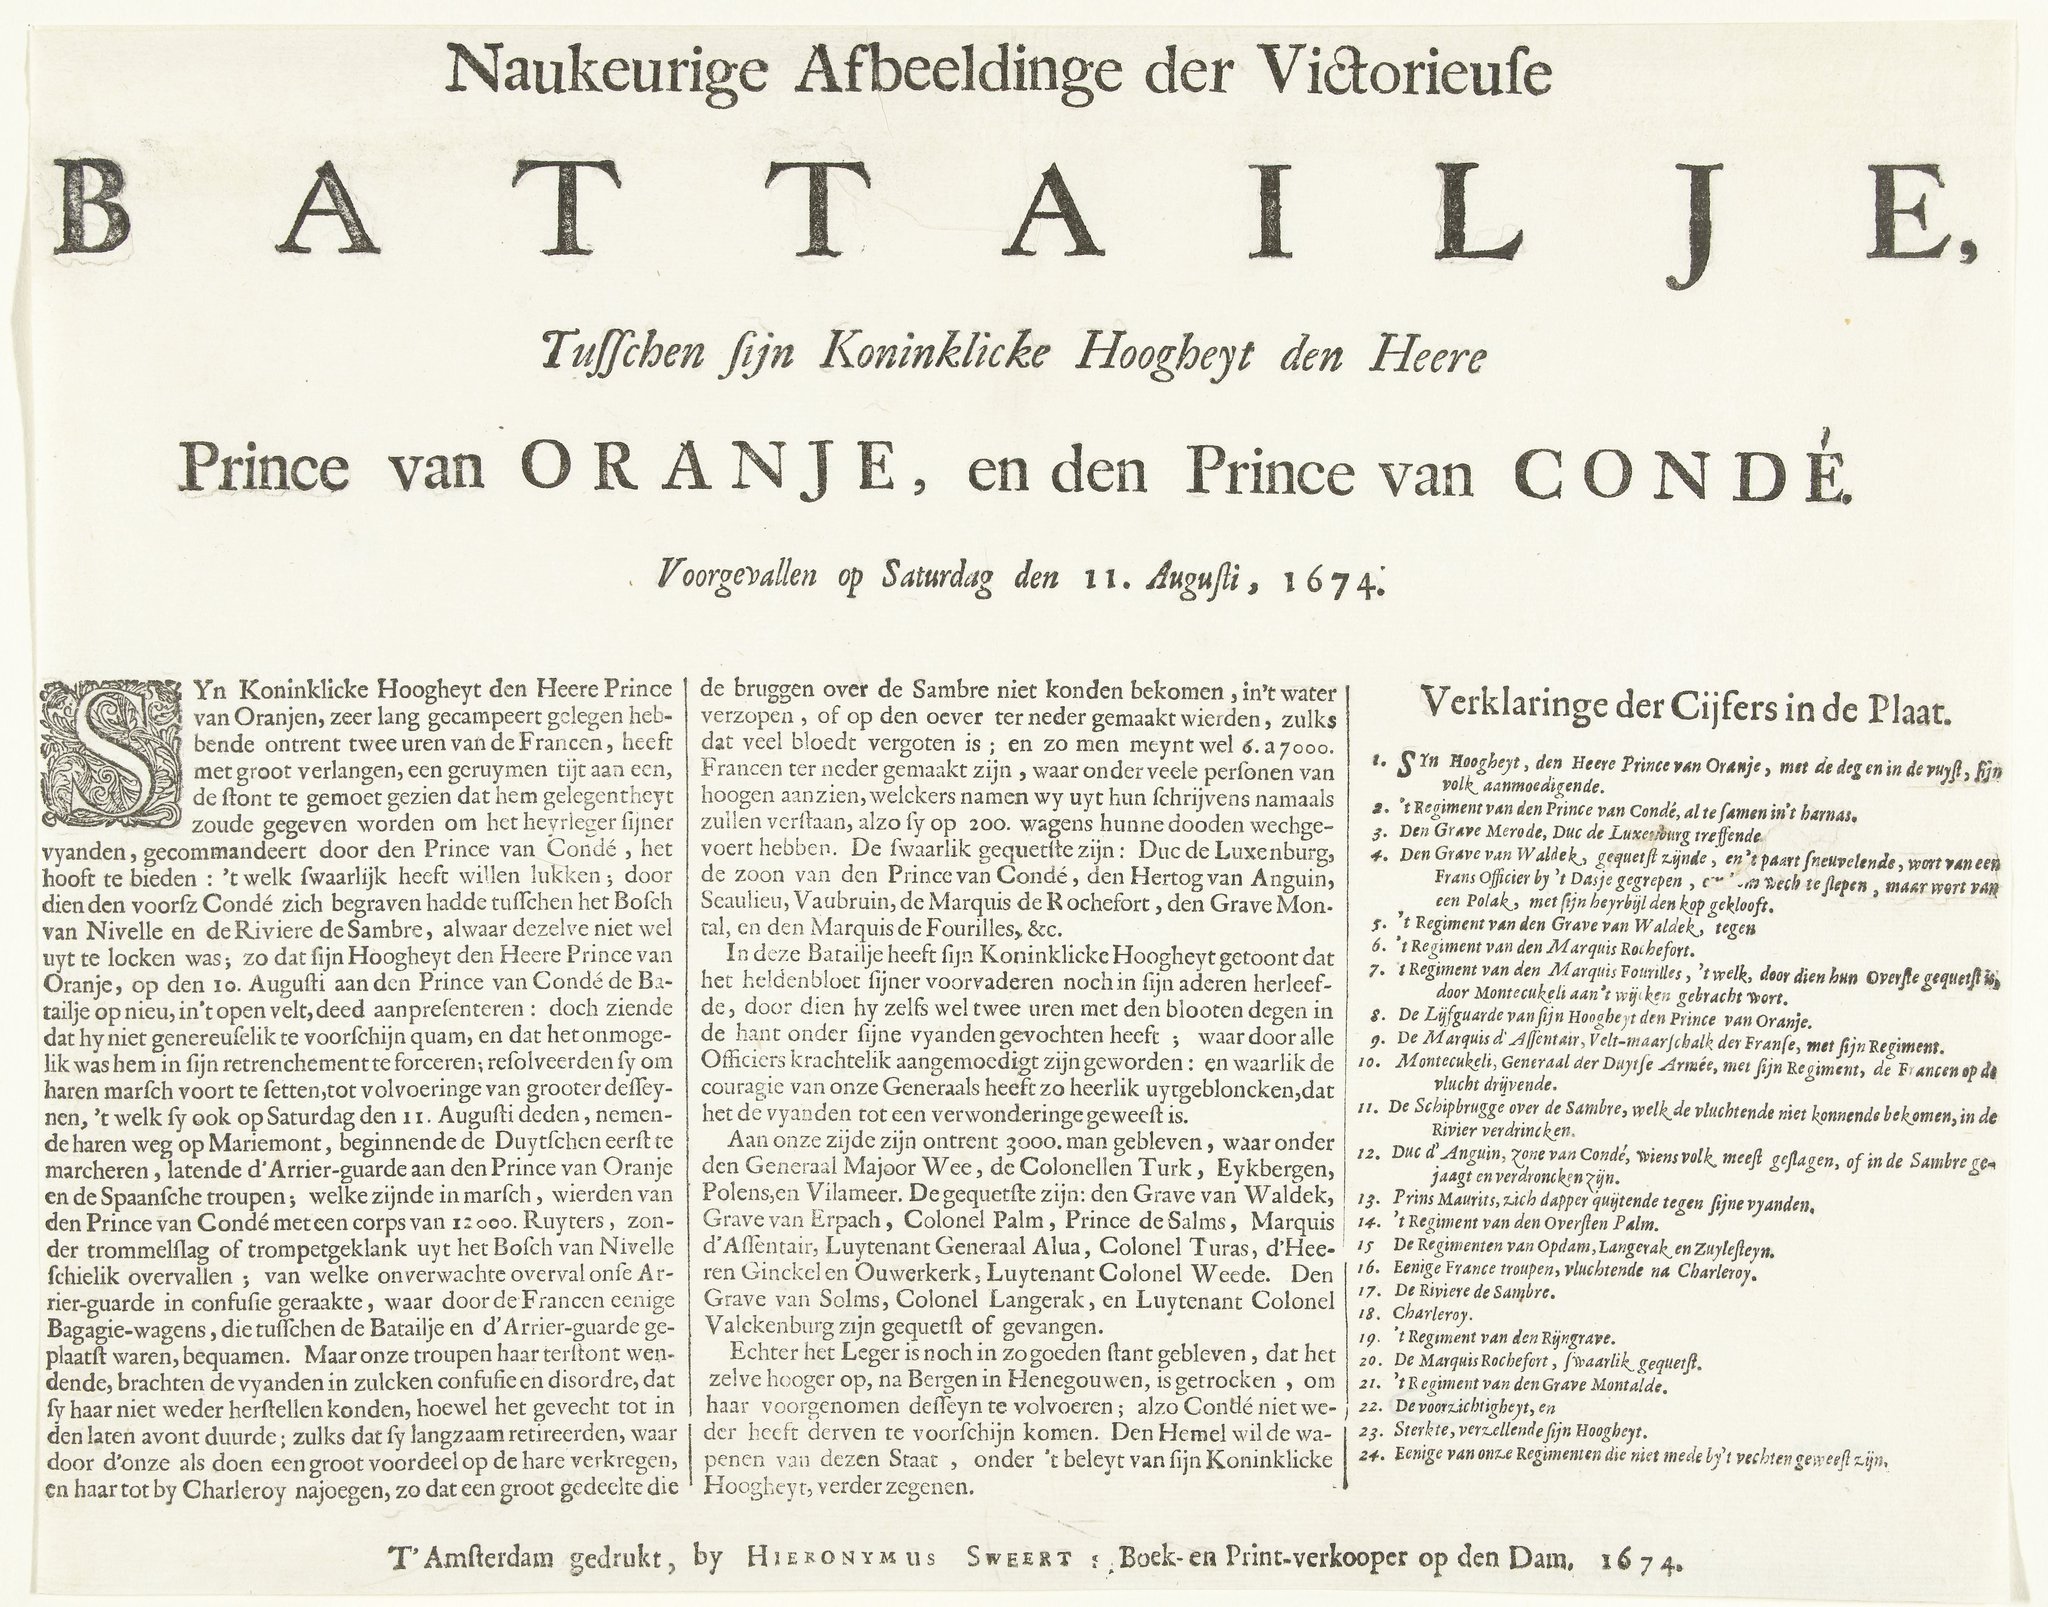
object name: text sheet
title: Naukeurige Afbeeldinge der Victorieuse Battailje, Tusschen sijn Koninklicke Hoogheyt den Heere Prince van Oranje, en den Prince van Condé. Voorgevallen op Saturdag den 11. Augusti, 1674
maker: hieronymus sweerts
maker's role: publisher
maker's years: 1629-1696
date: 1674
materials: paper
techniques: letterpress printing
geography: amsterdam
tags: william iii (prince of orange and king of england, scotland, and ireland), paris, lodewijk ii de bourbon-condé (hertog van enghien)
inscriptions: date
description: Tekstblad bij de prent van de Slag bij Seneffe op 11 juli 1674 tussen de geallieerde Staatse troepen onder Willem III en de Spaanse en keizerlijke troepen enerzijds en de Fransen onder de prins van Condé anderzijds. Tekst in 3 kolommen met de legenda 1-24.